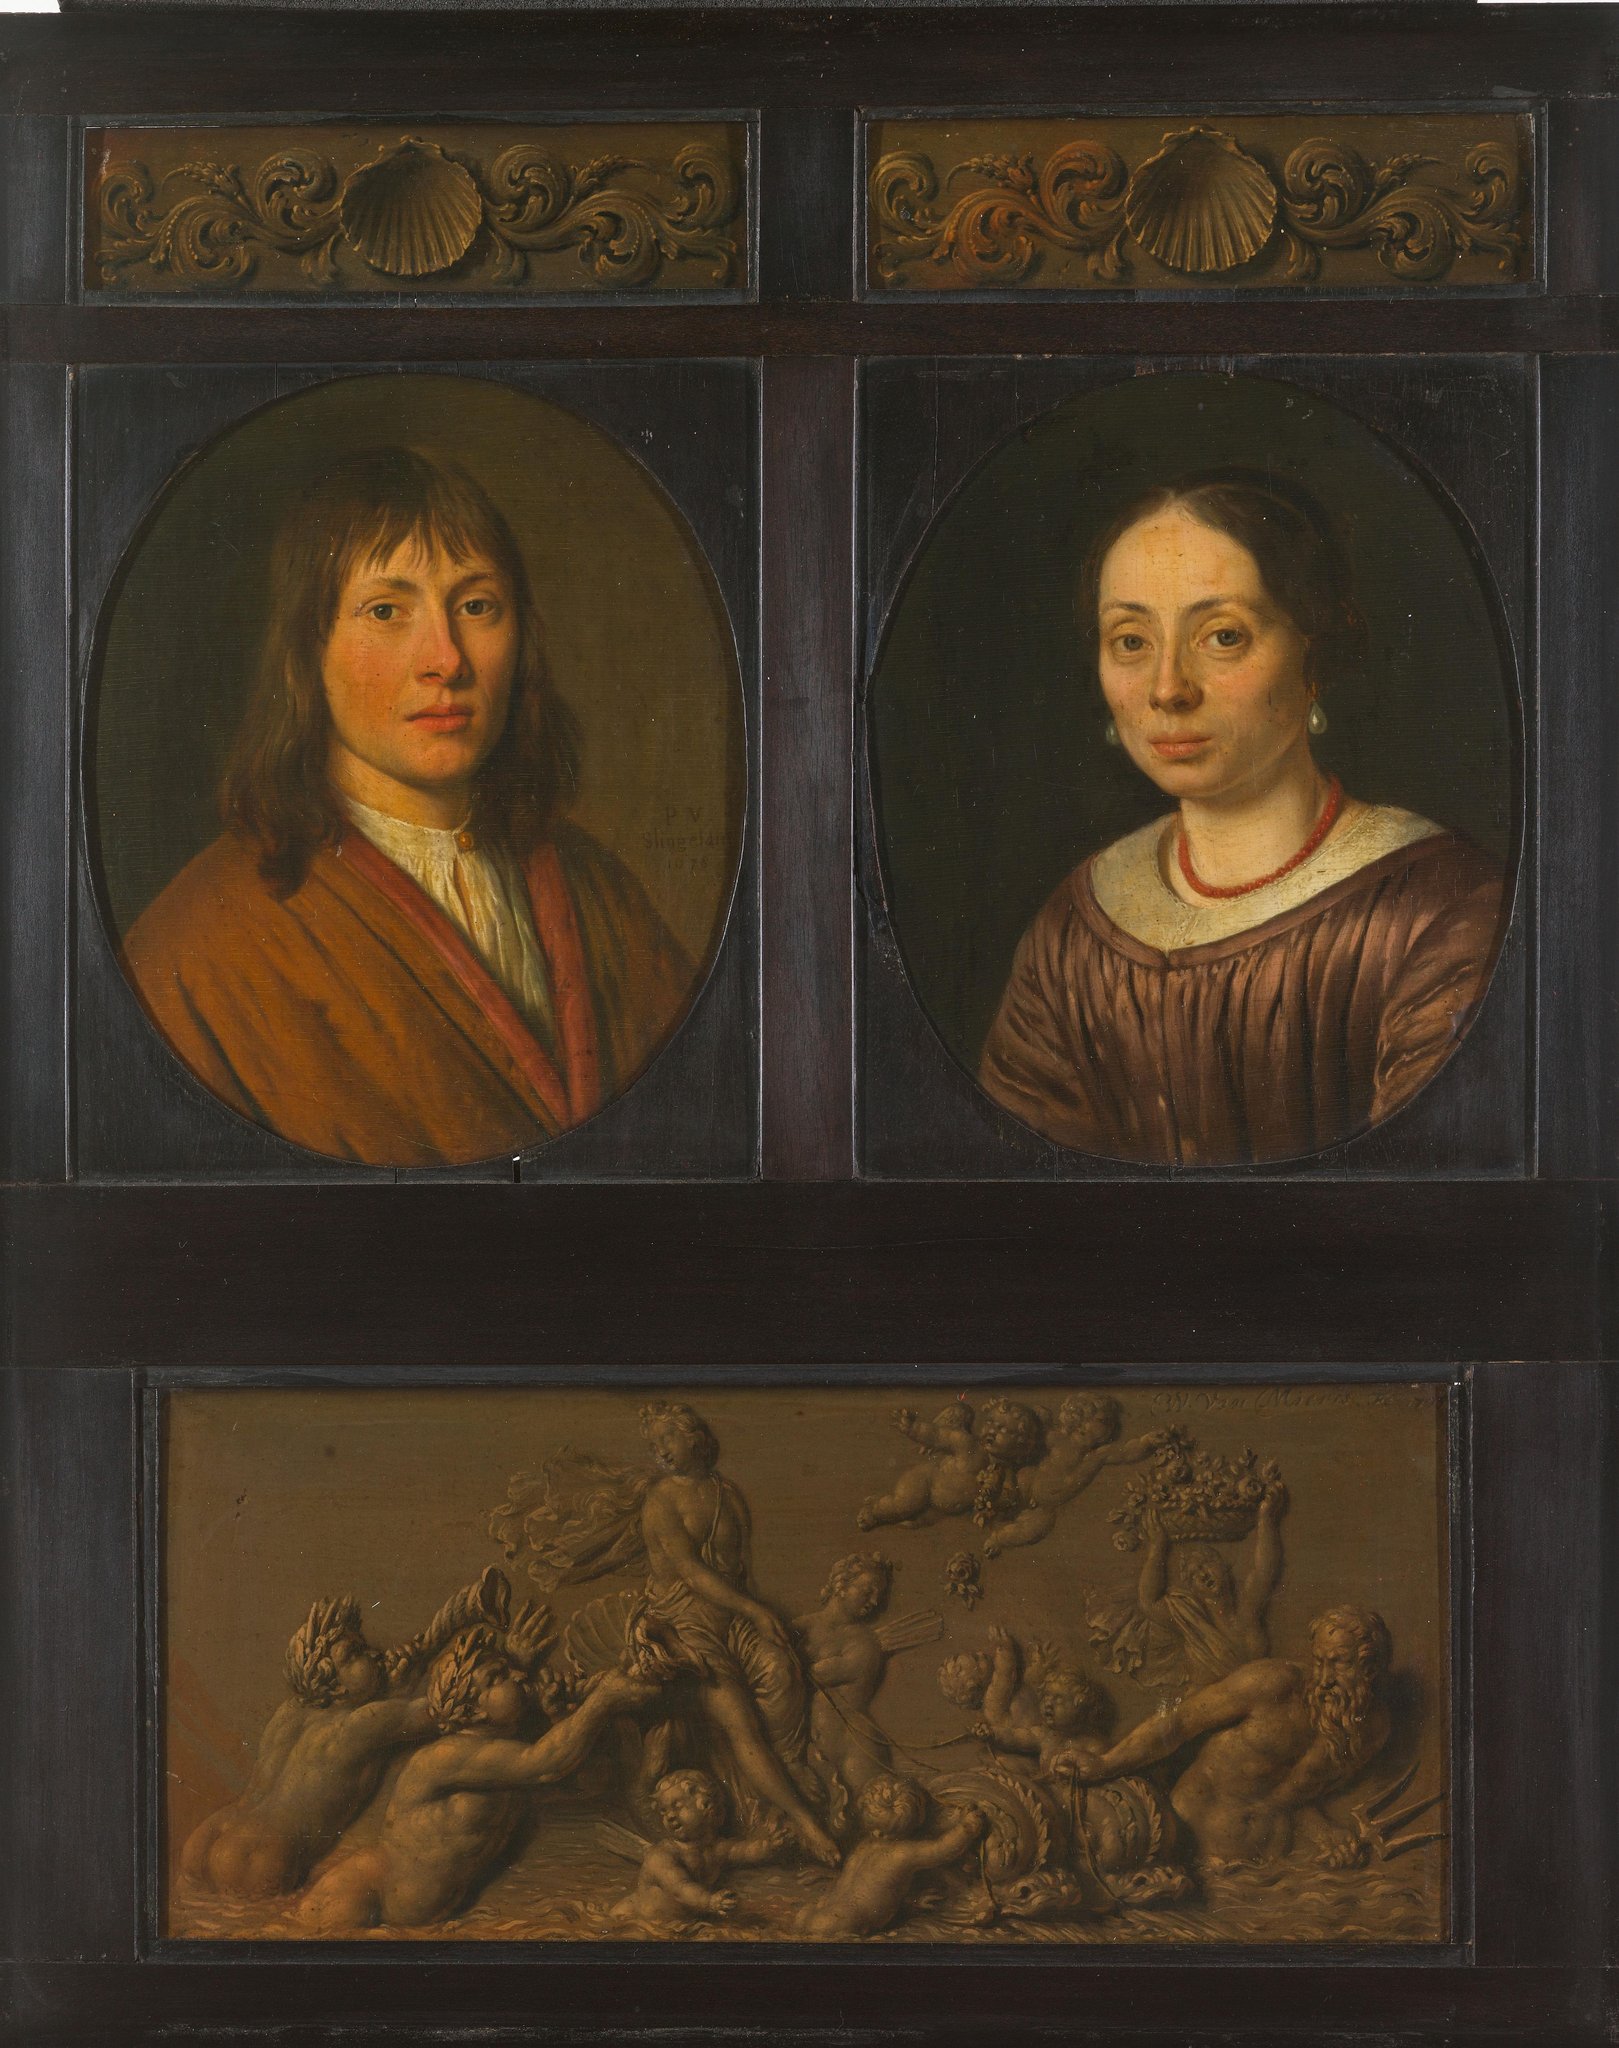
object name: grisaille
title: Portraits of a Man and a Woman framed with two ornamental frieze miniatures with shell motif and a Triumph of Amphitrite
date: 1678-1705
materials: copper, oil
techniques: grisaille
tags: historical persons not known by name - bb - woman, triumph of amphitrite, historical persons not known by name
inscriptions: signature and date: ‘PV Slingeland 1678’, signature and date: ‘W. van Mieris Fe. 1705’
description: Pieter van Slingelandt (1640 - 1691). Portrait of a man, dated 1678, and a woman. Willem van Mieris (1662 - 1747). The triumph of Amphitrite, dated 1705, and two ornamental friezes with shell motifs. Five panels, mounted in a 17th- century ebony frame. Purchased with the support of the Vereniging Rembrandt, 1902.